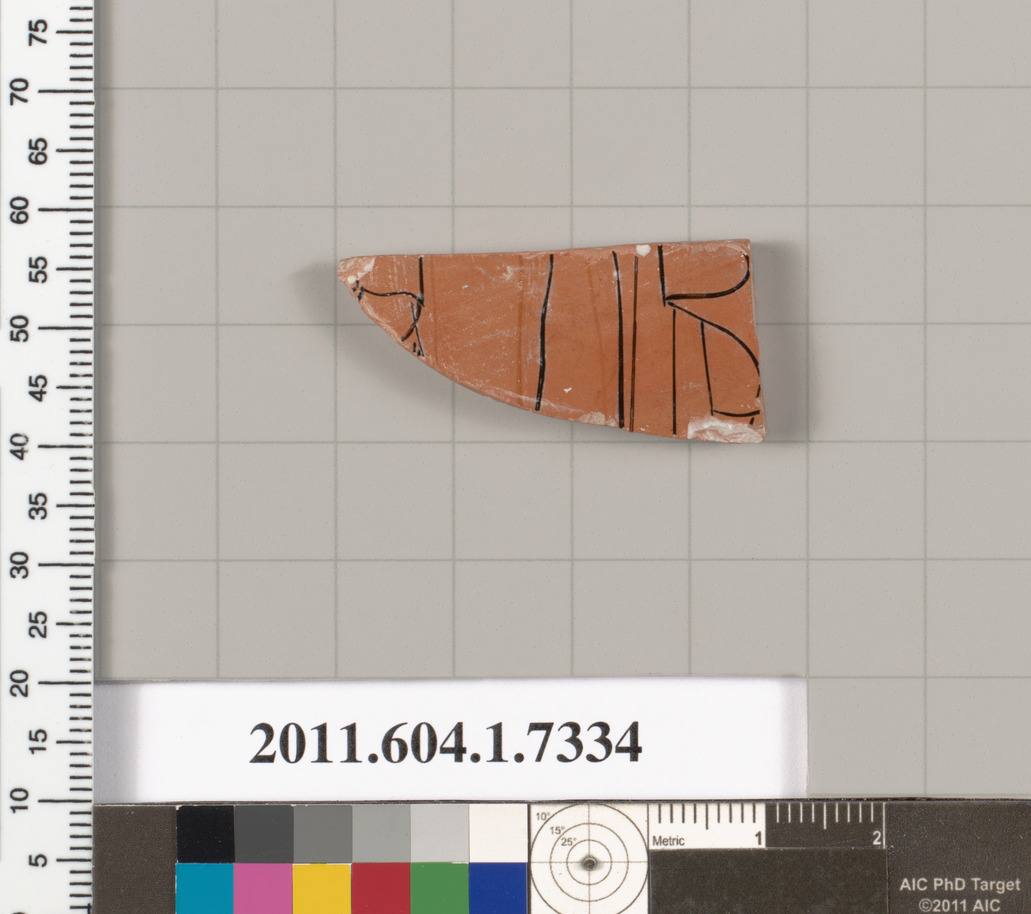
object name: kylix fragment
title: Terracotta fragment of a kylix (drinking cup)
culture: greek, attic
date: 500-480 BCE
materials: terracotta